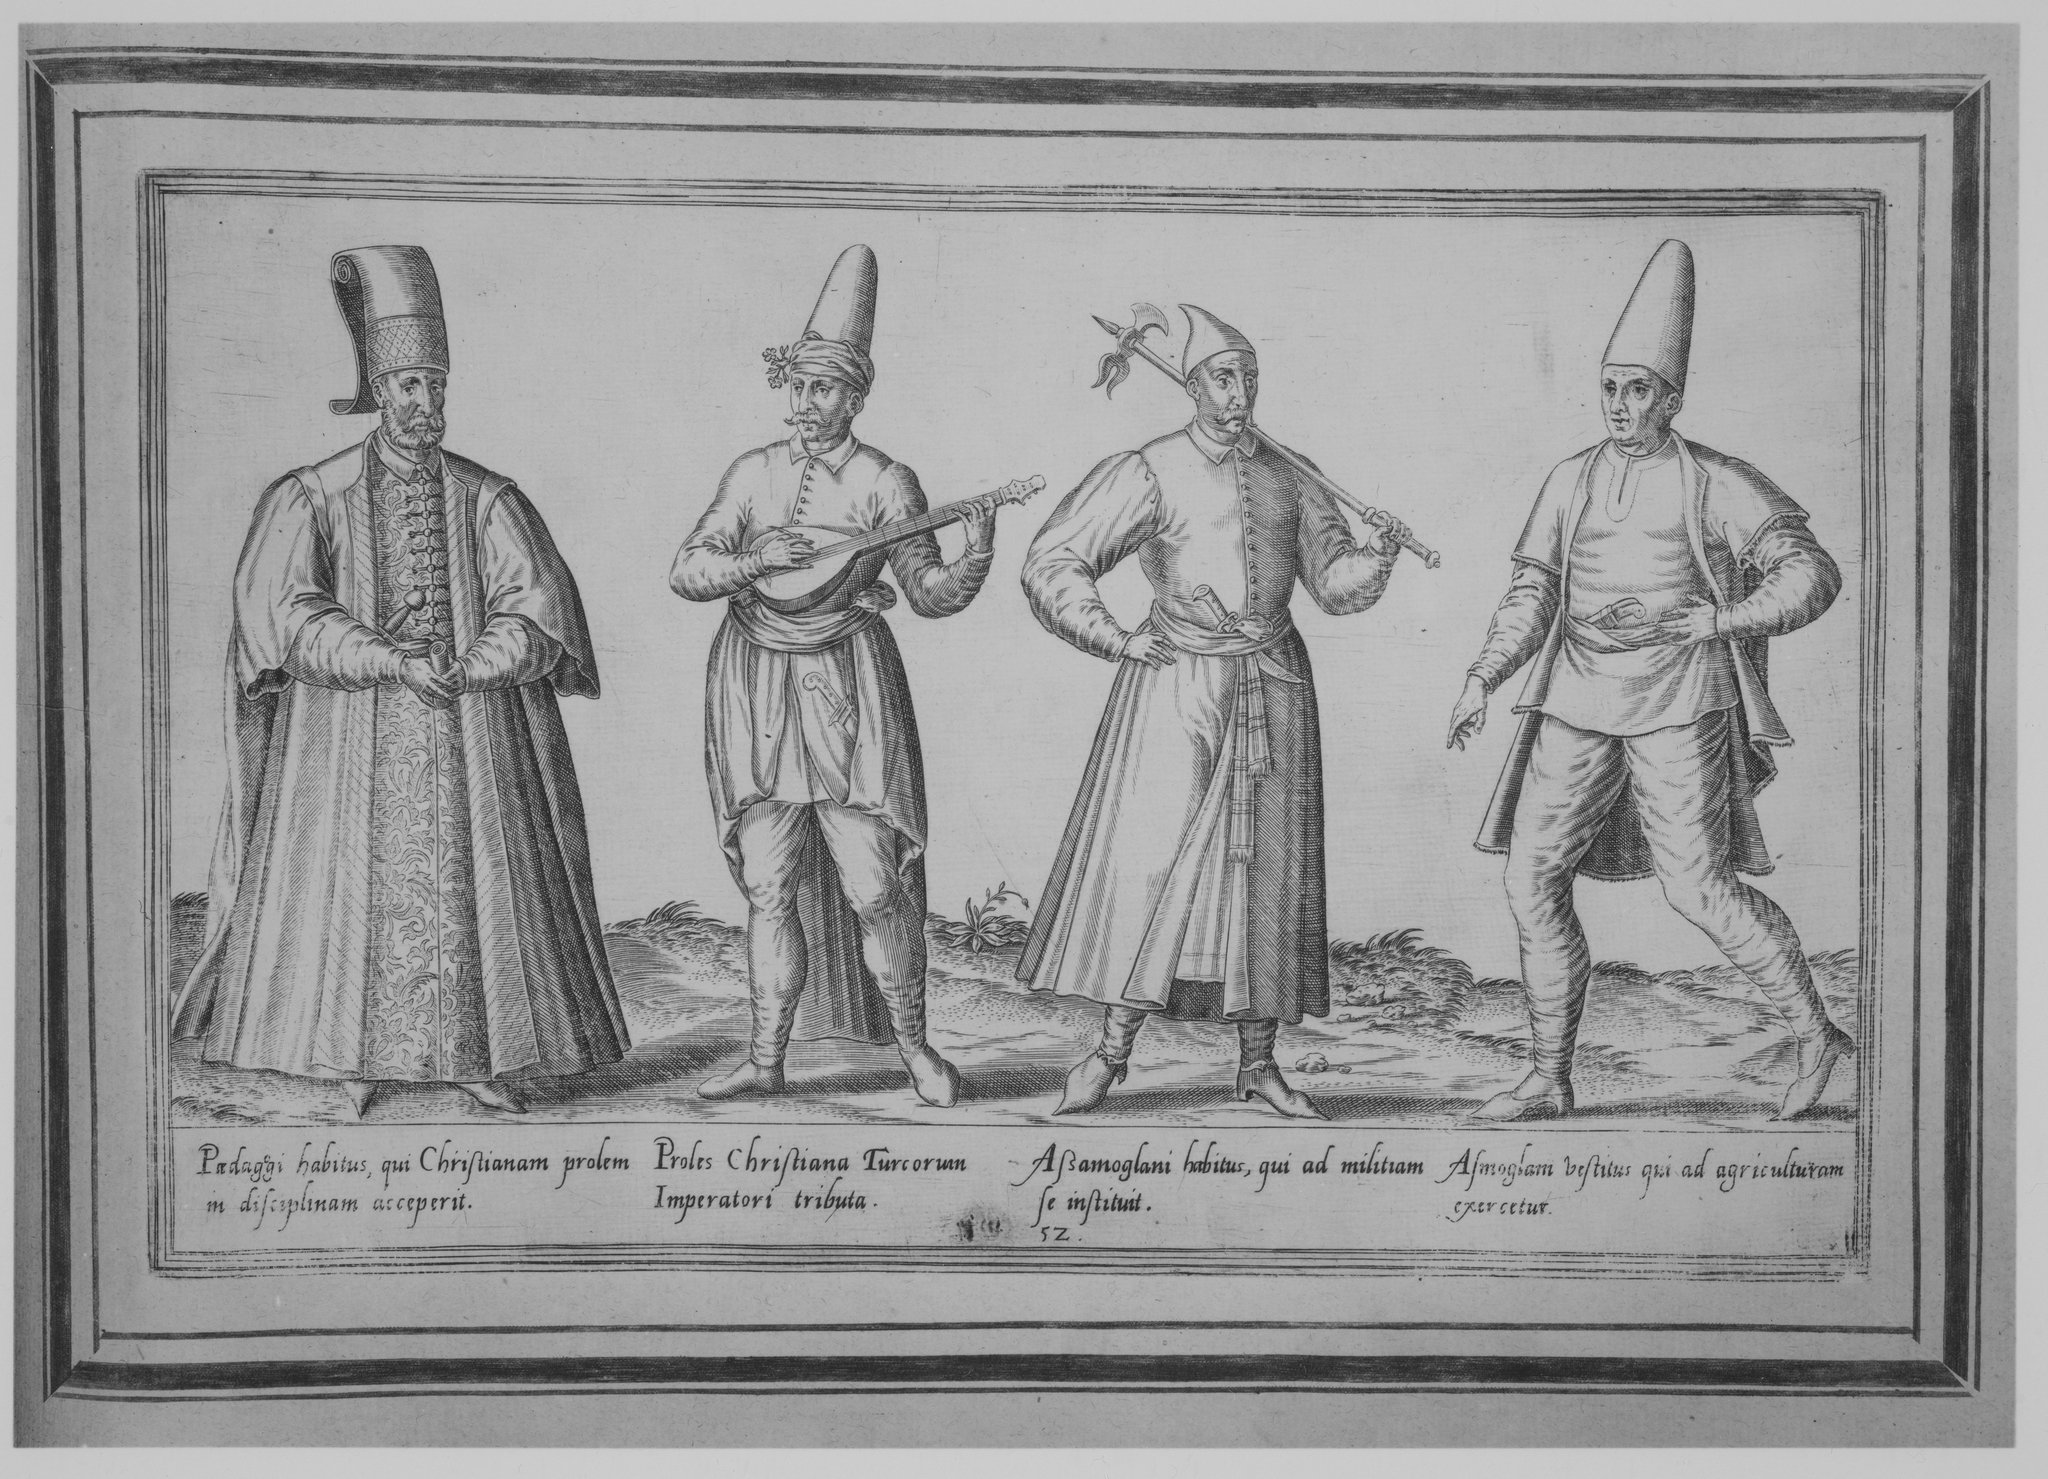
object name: book print ornament architecture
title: Paedagogi habitus, qui Christianam prolem in disceplinam acceperit; Proles Christiana Turcorum Imperatori tributa; Assamoglani habitus, qui ad militiam se instituit; Asmoglam vestituis qui ad agriculturam exercetur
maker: abraham de bruyn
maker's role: artist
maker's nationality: flemish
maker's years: 1540-1587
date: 1580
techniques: engraving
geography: mechelen (malines)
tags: musical instruments,men